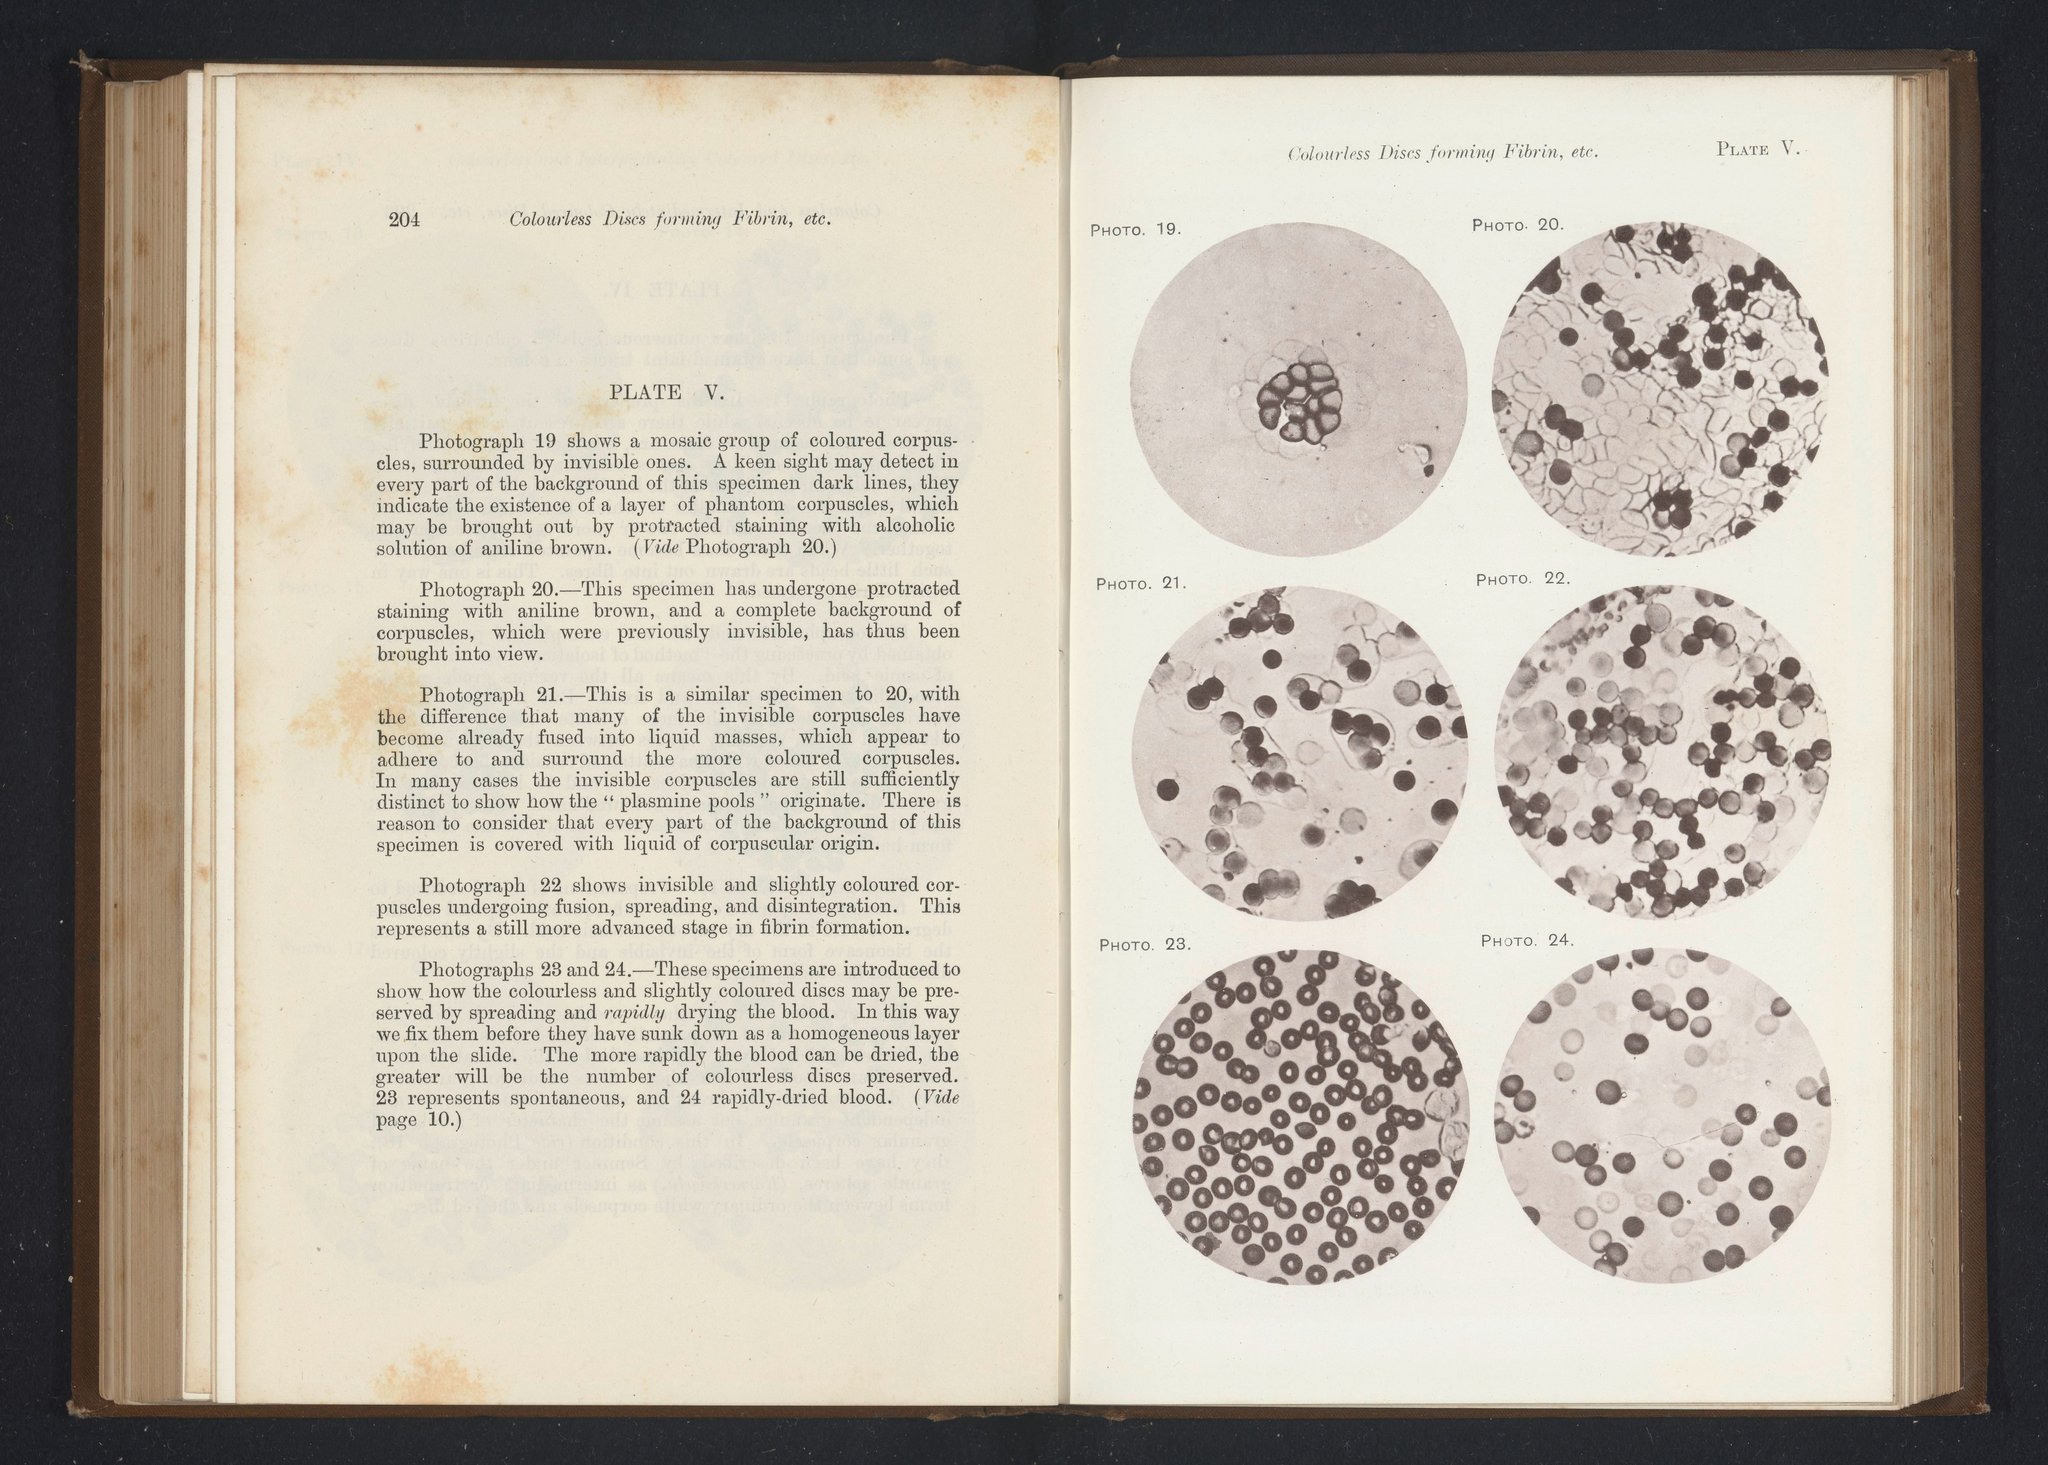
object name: photomechanical print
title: Zes vergrotingen van bloedcellen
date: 1872-1882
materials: paper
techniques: photograph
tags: blood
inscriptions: number: ‘Pl. V.’, number: ‘Photo. 19. (...) Photo. 24.’